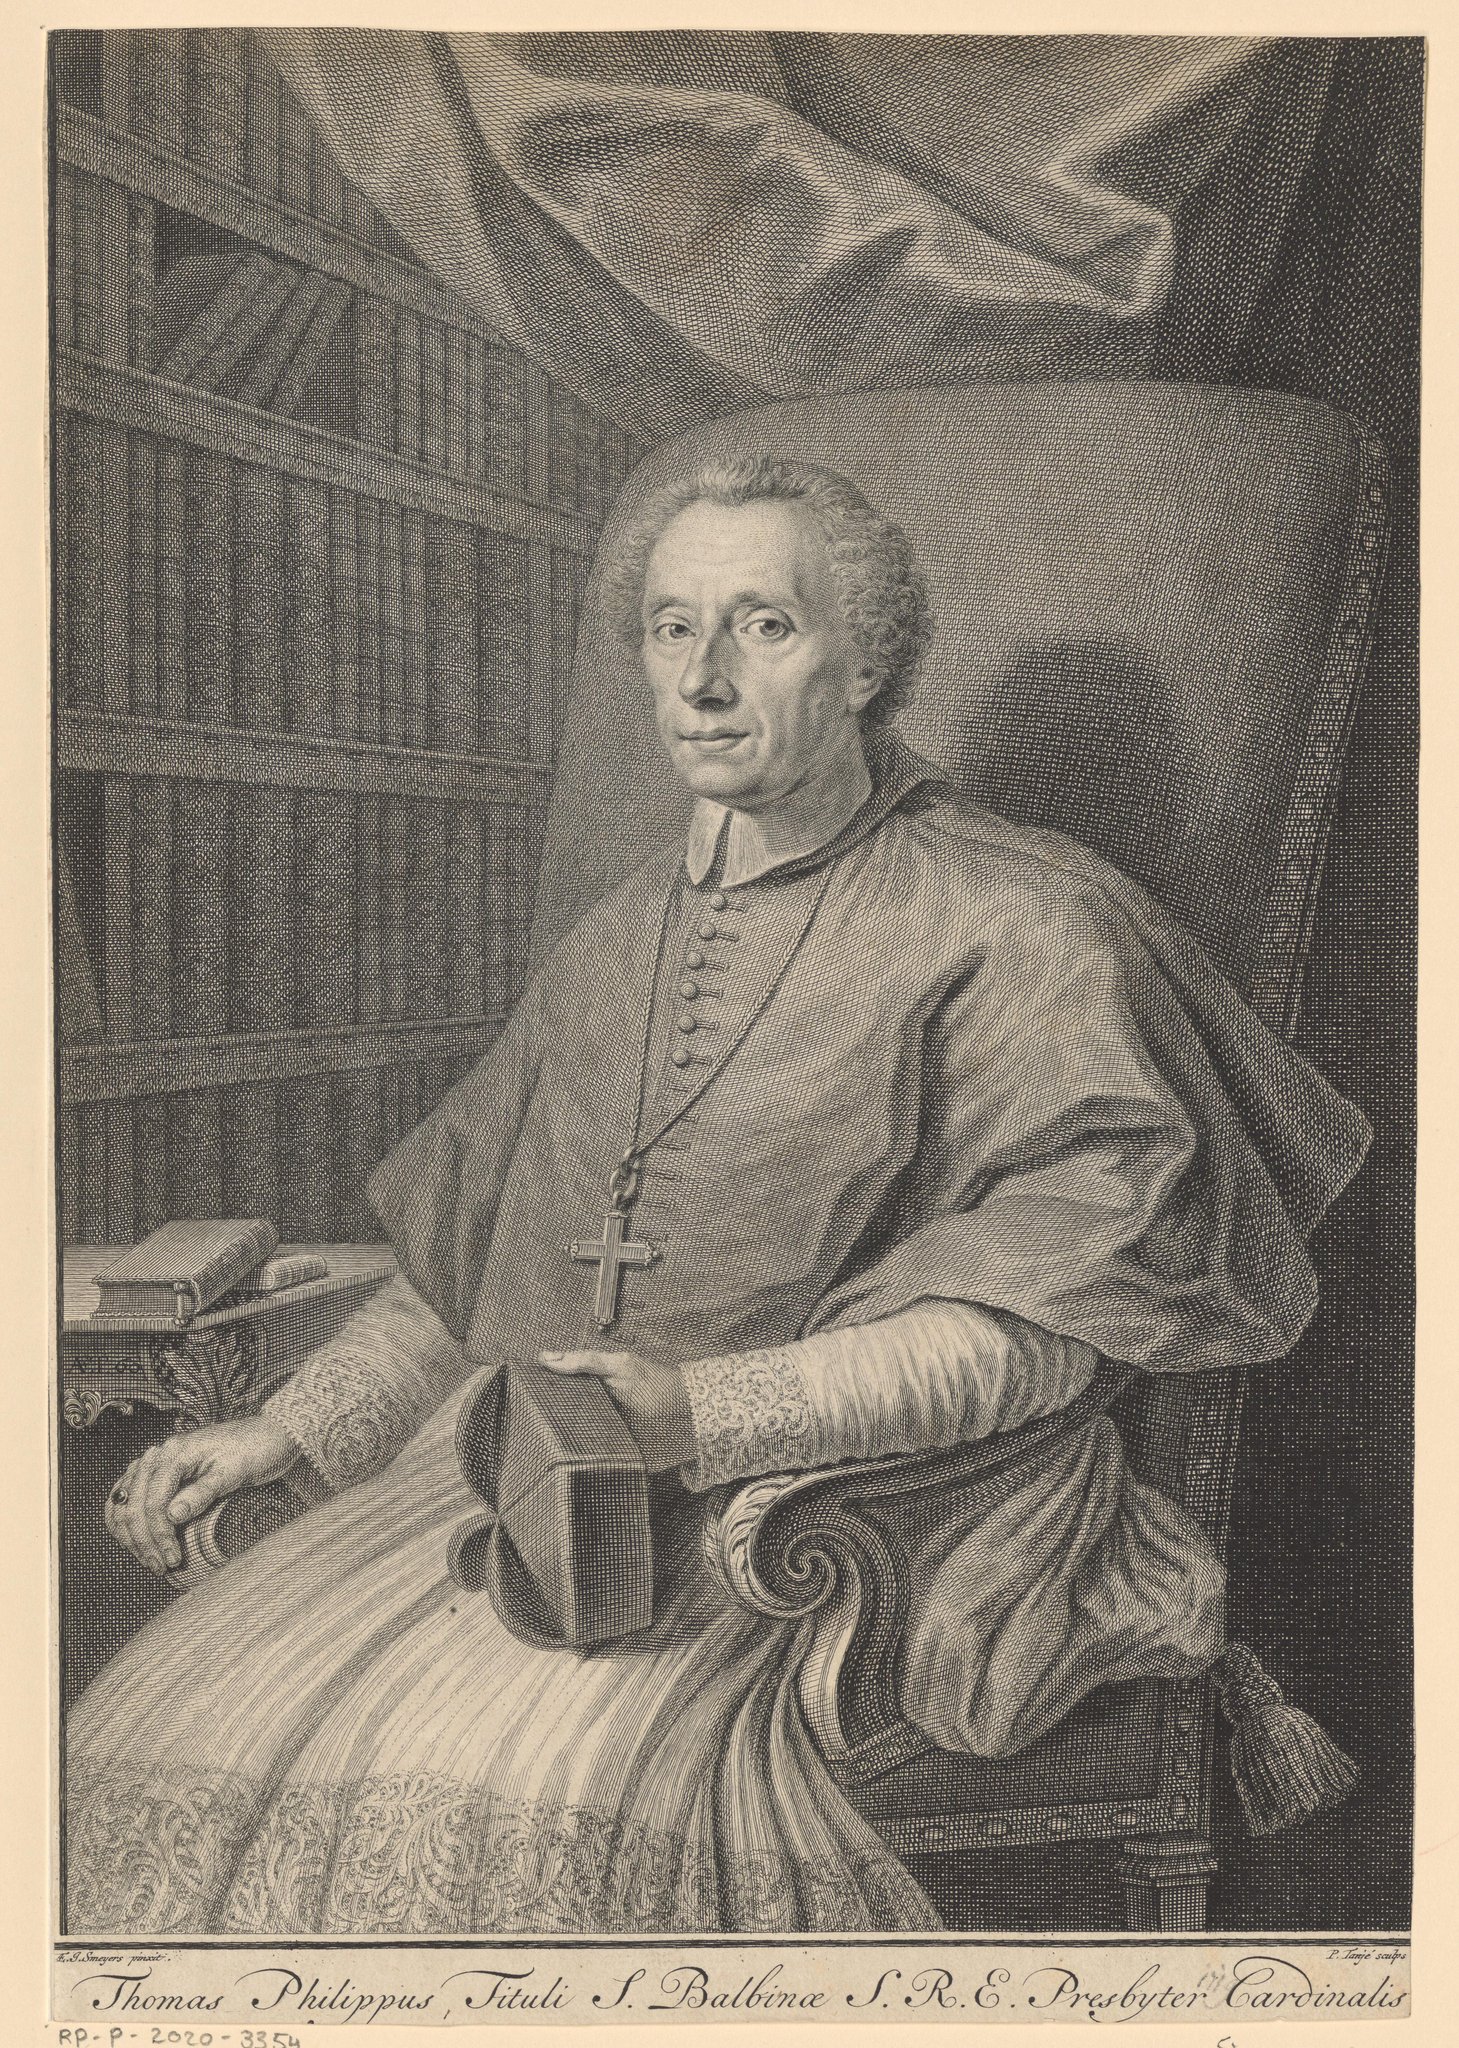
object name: print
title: Portret van Thomas Philippus d'Alsace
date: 1719-1761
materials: paper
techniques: engraving, etching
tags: bookshelves, cardinal, historical persons